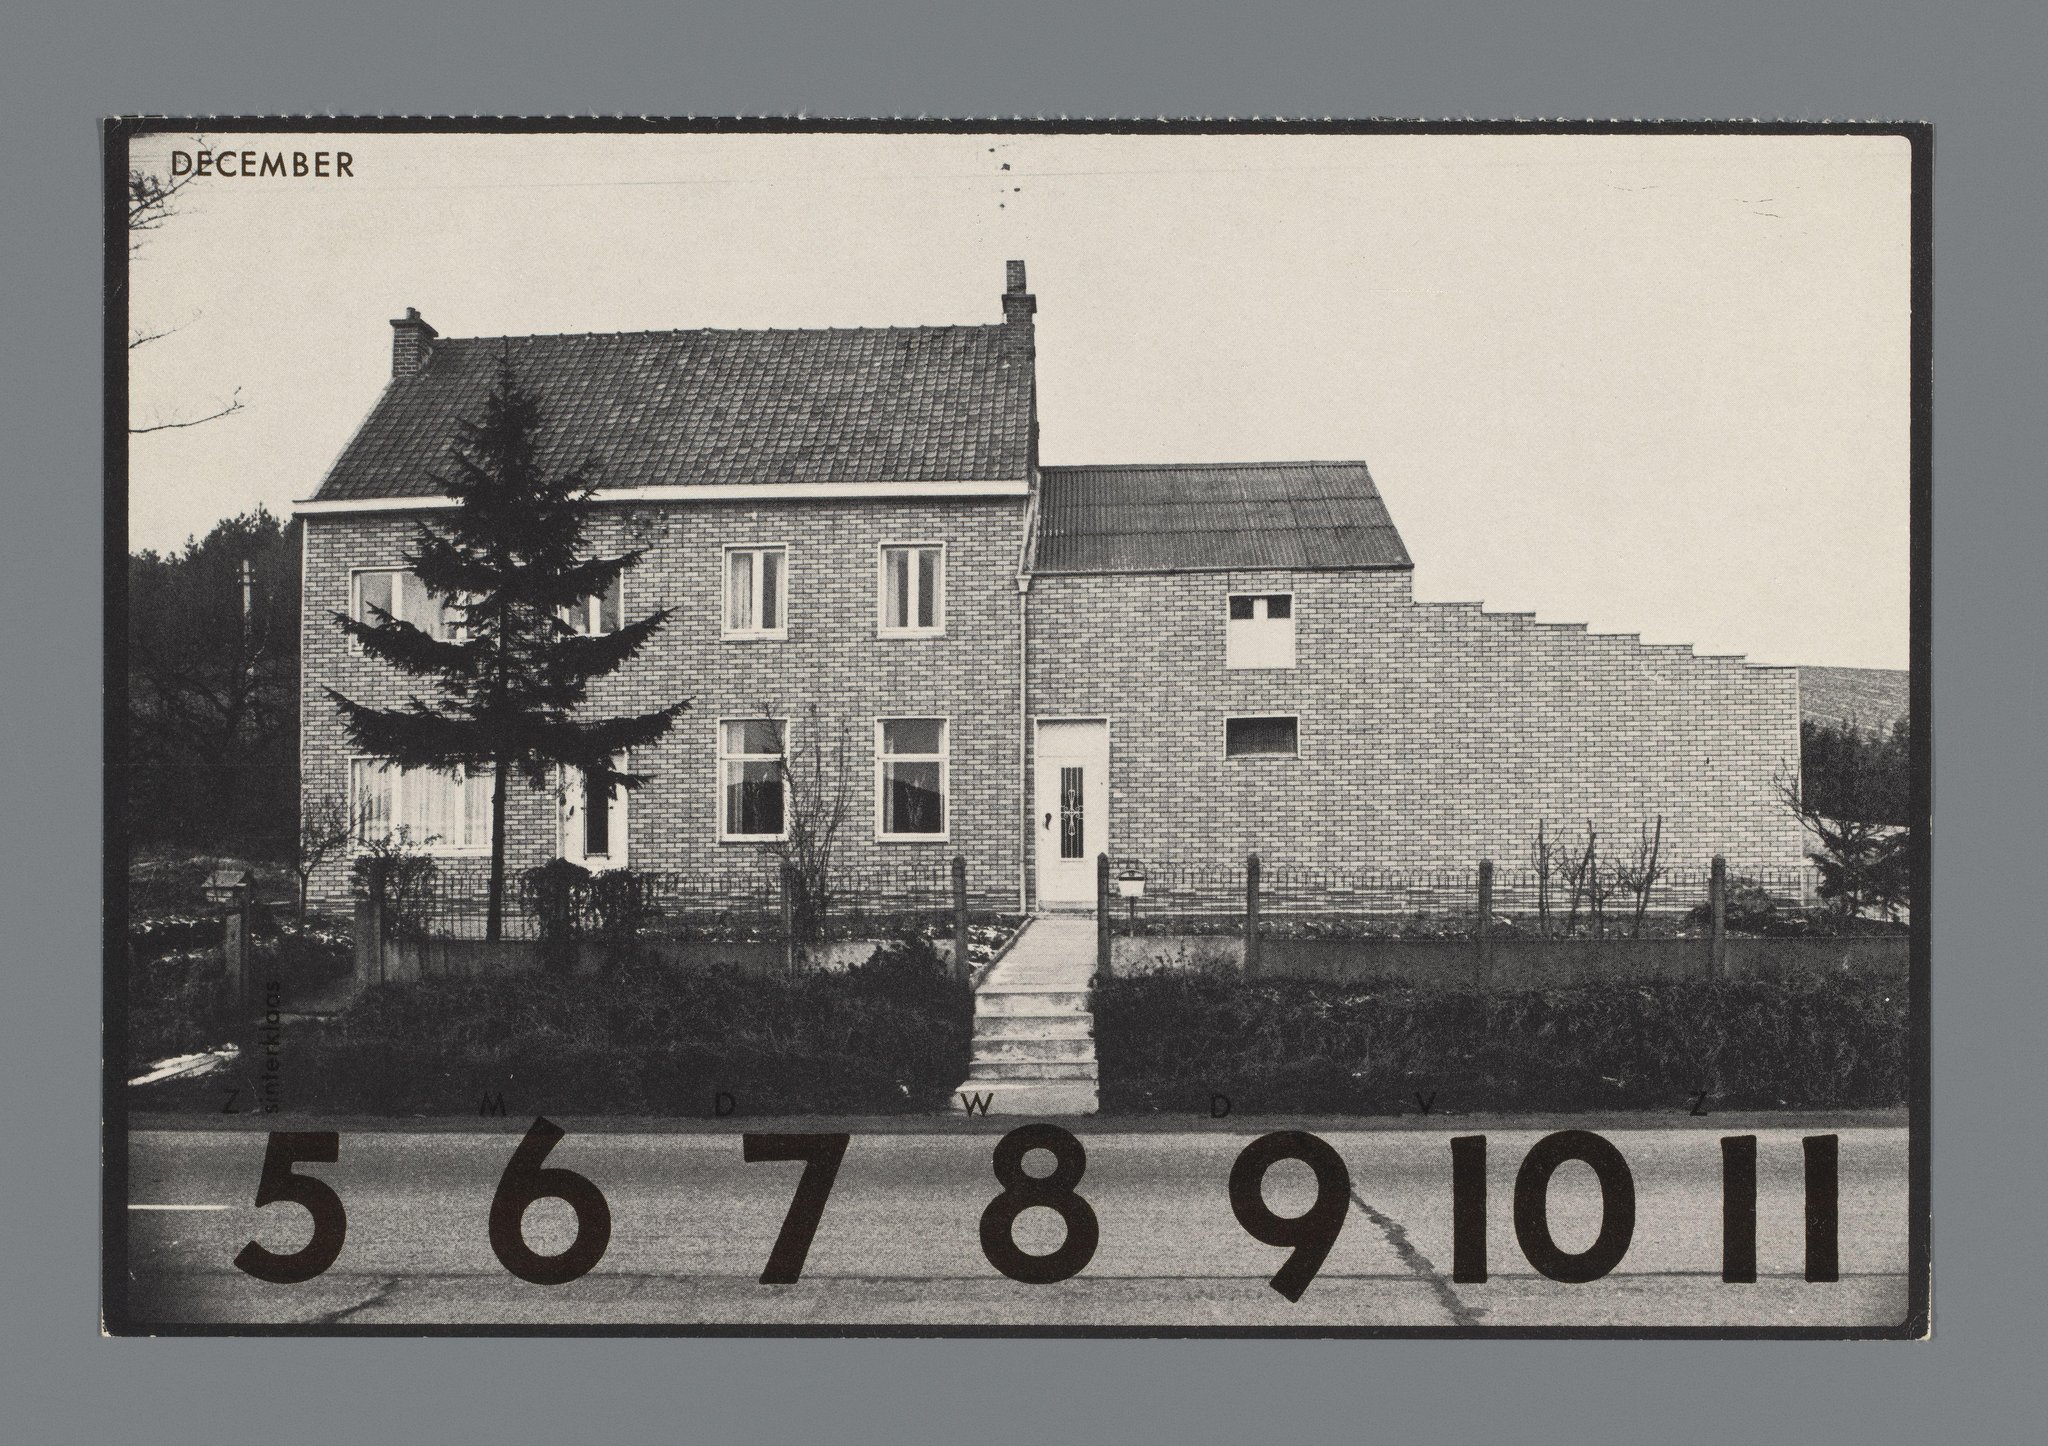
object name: photograph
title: België. Huizen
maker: Anonymous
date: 1900-1950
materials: paper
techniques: offset printed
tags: belgium